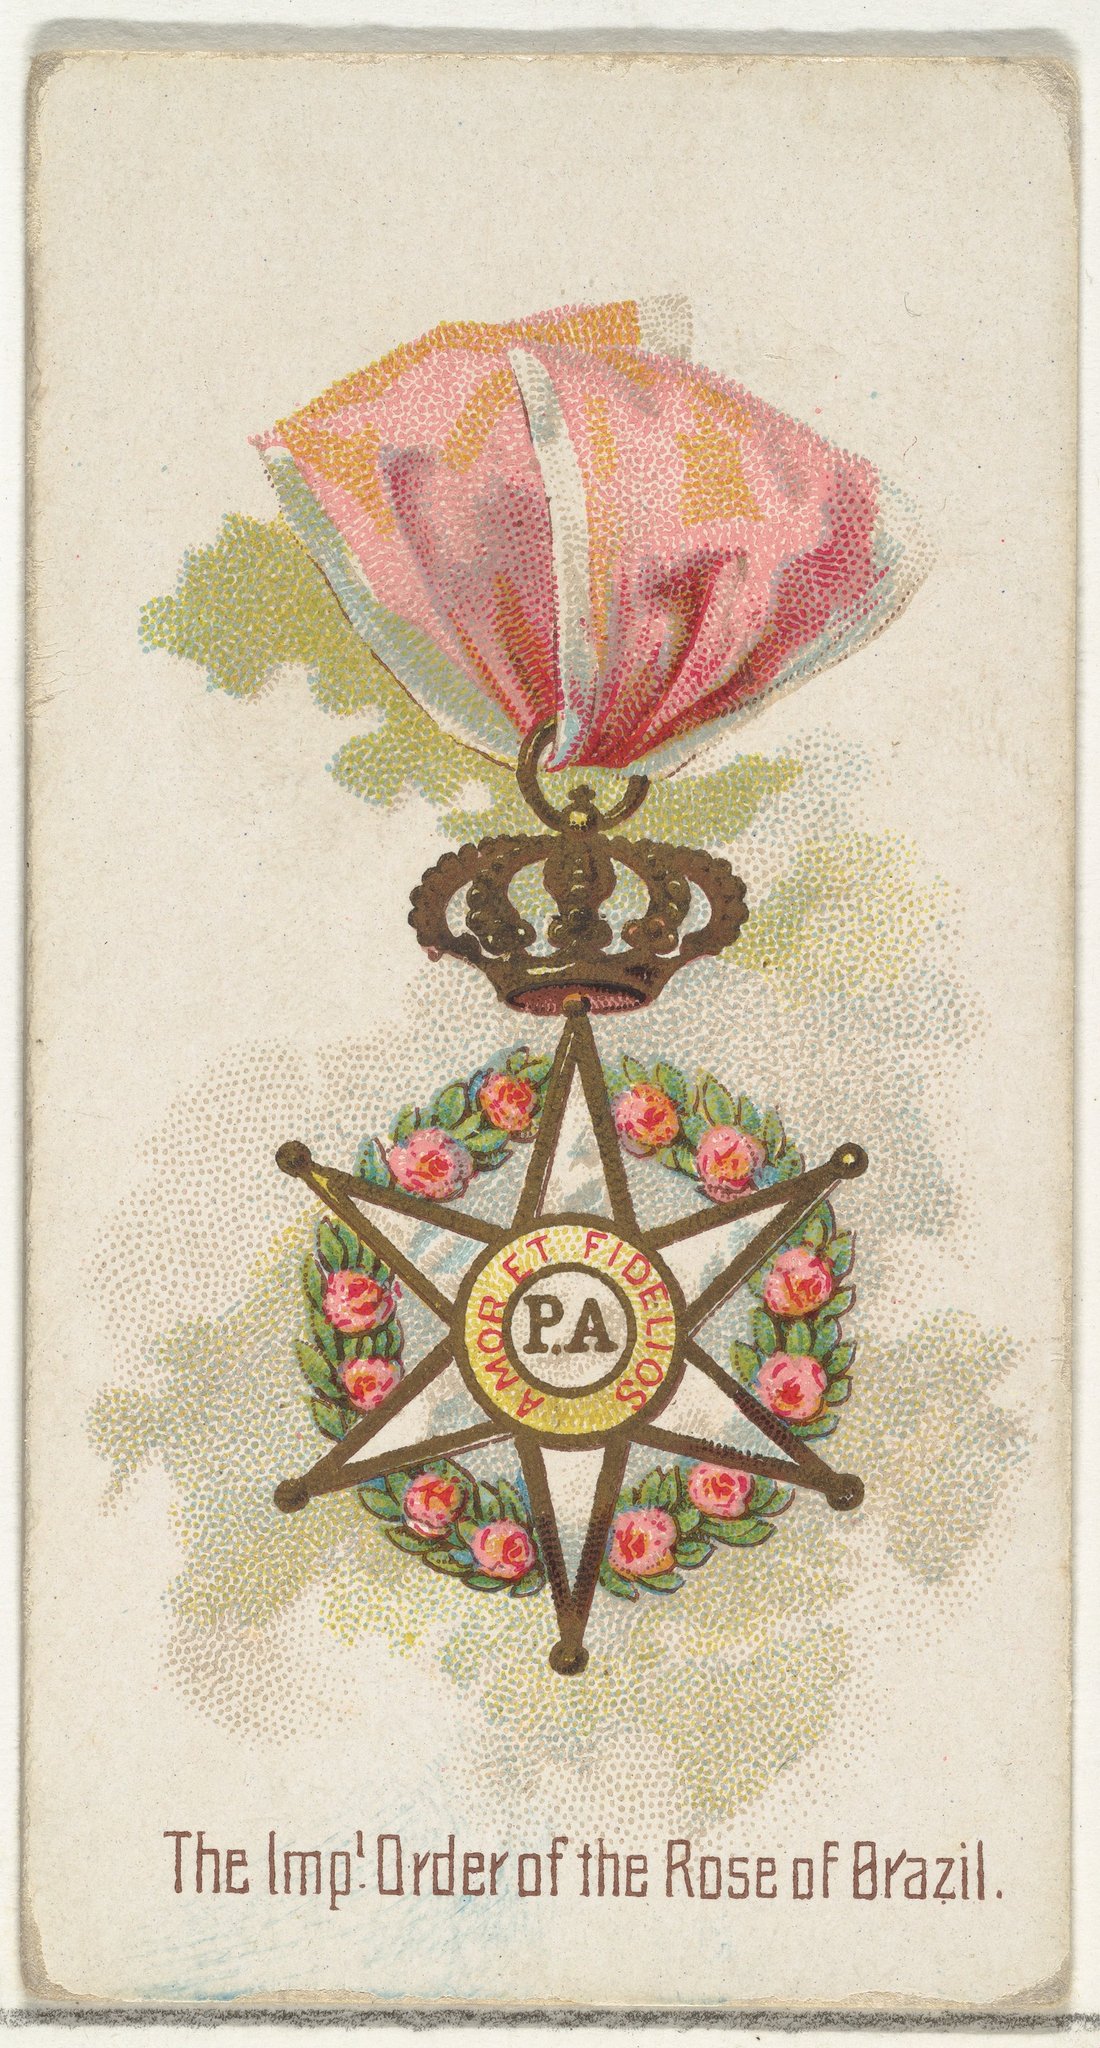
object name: print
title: The Imperial Order of the Rose of Brazil, from the World's Decorations series (N30) for Allen & Ginter Cigarettes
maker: allen & ginter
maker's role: publisher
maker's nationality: american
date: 1890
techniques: color lithograph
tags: medals